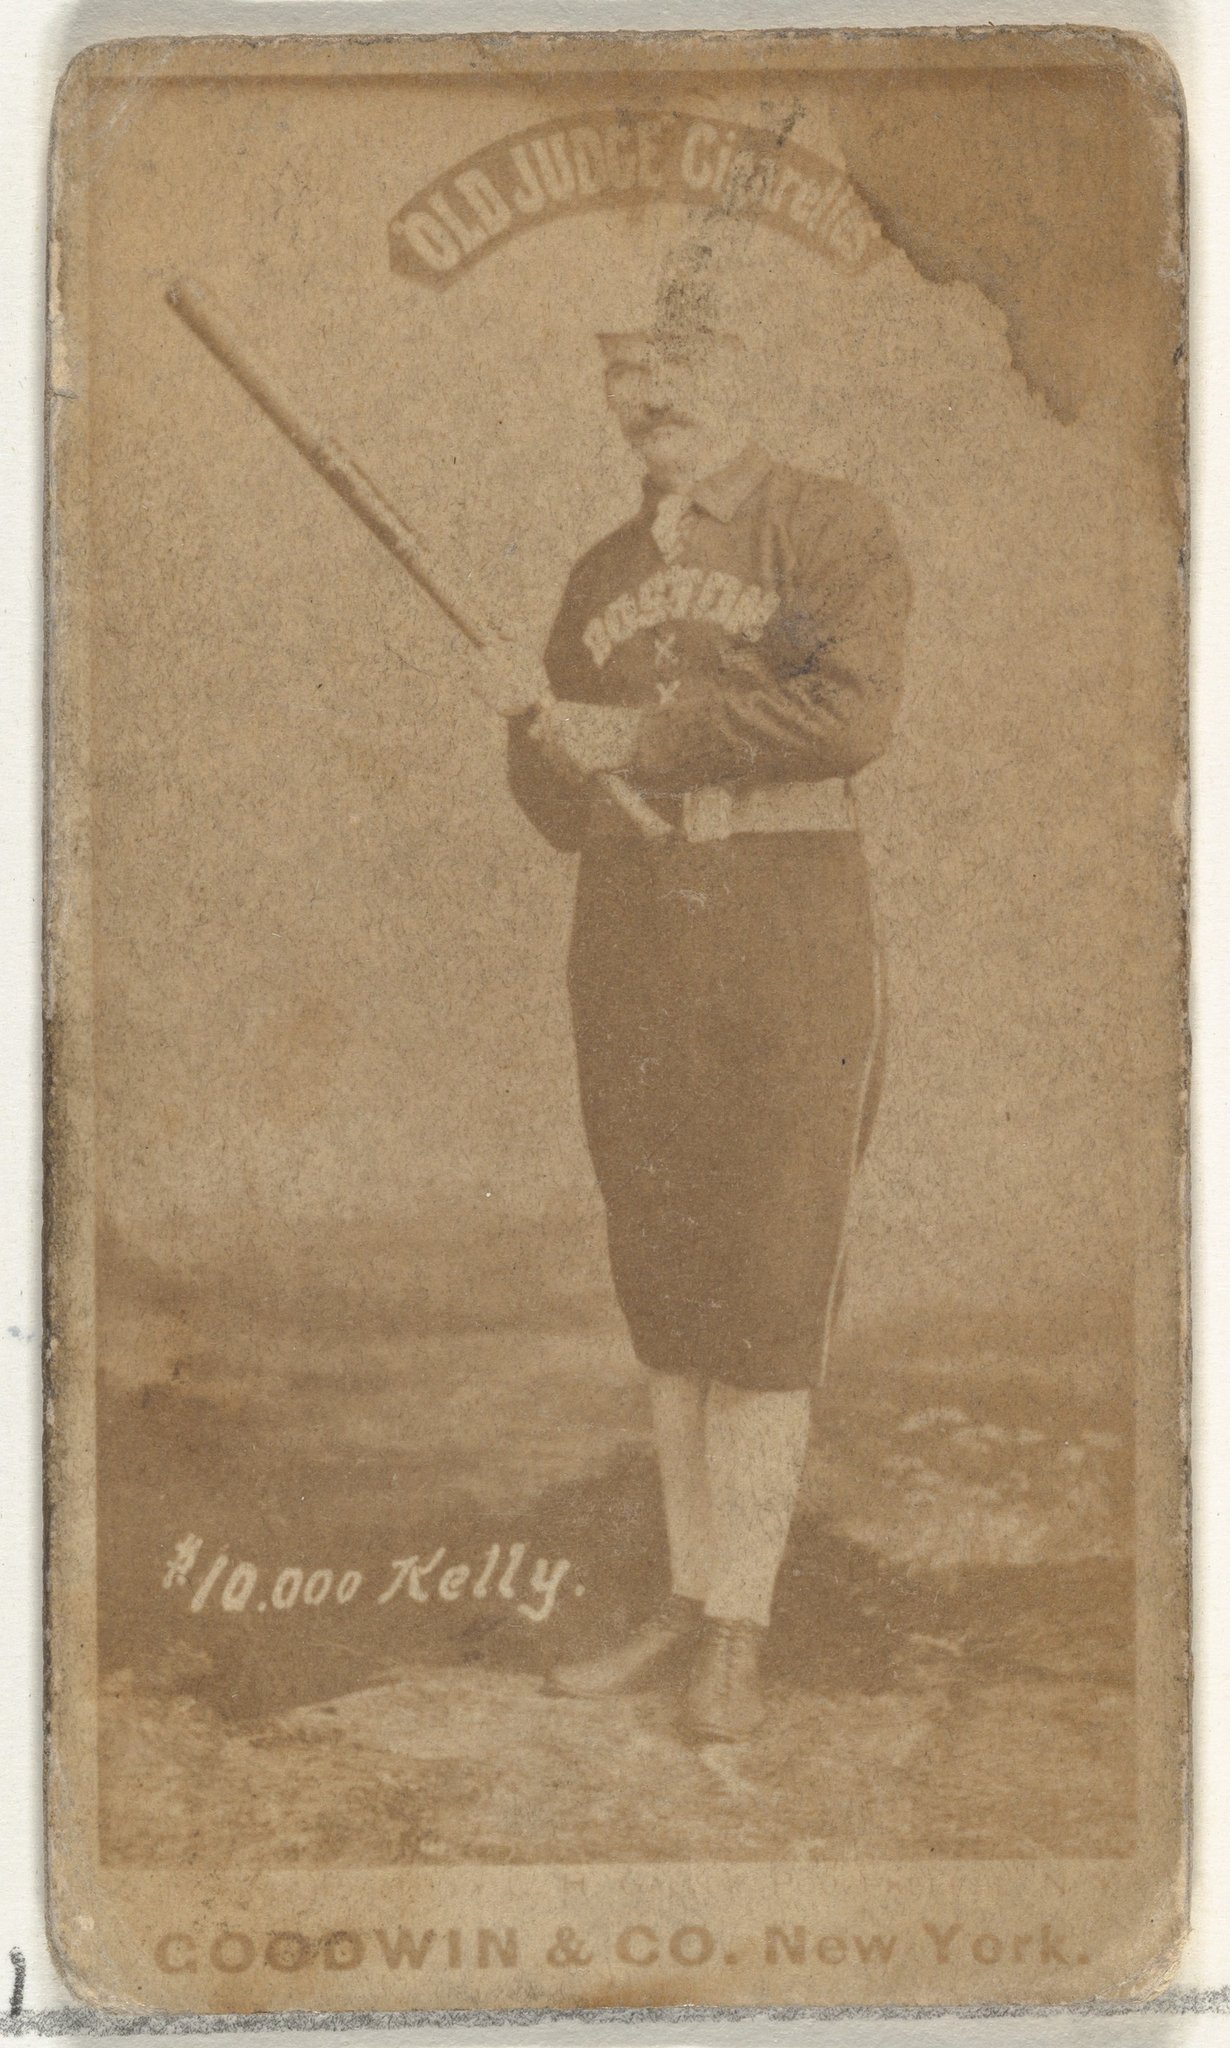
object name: baseball card, photograph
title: Michael Joseph "$10,000" Kelly, from the Old Judge series (N172) for Old Judge Cigarettes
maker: goodwin & company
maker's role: publisher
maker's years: 1850-1950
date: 1887-1890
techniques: albumen silver print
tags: men,portraits,baseball,athletes